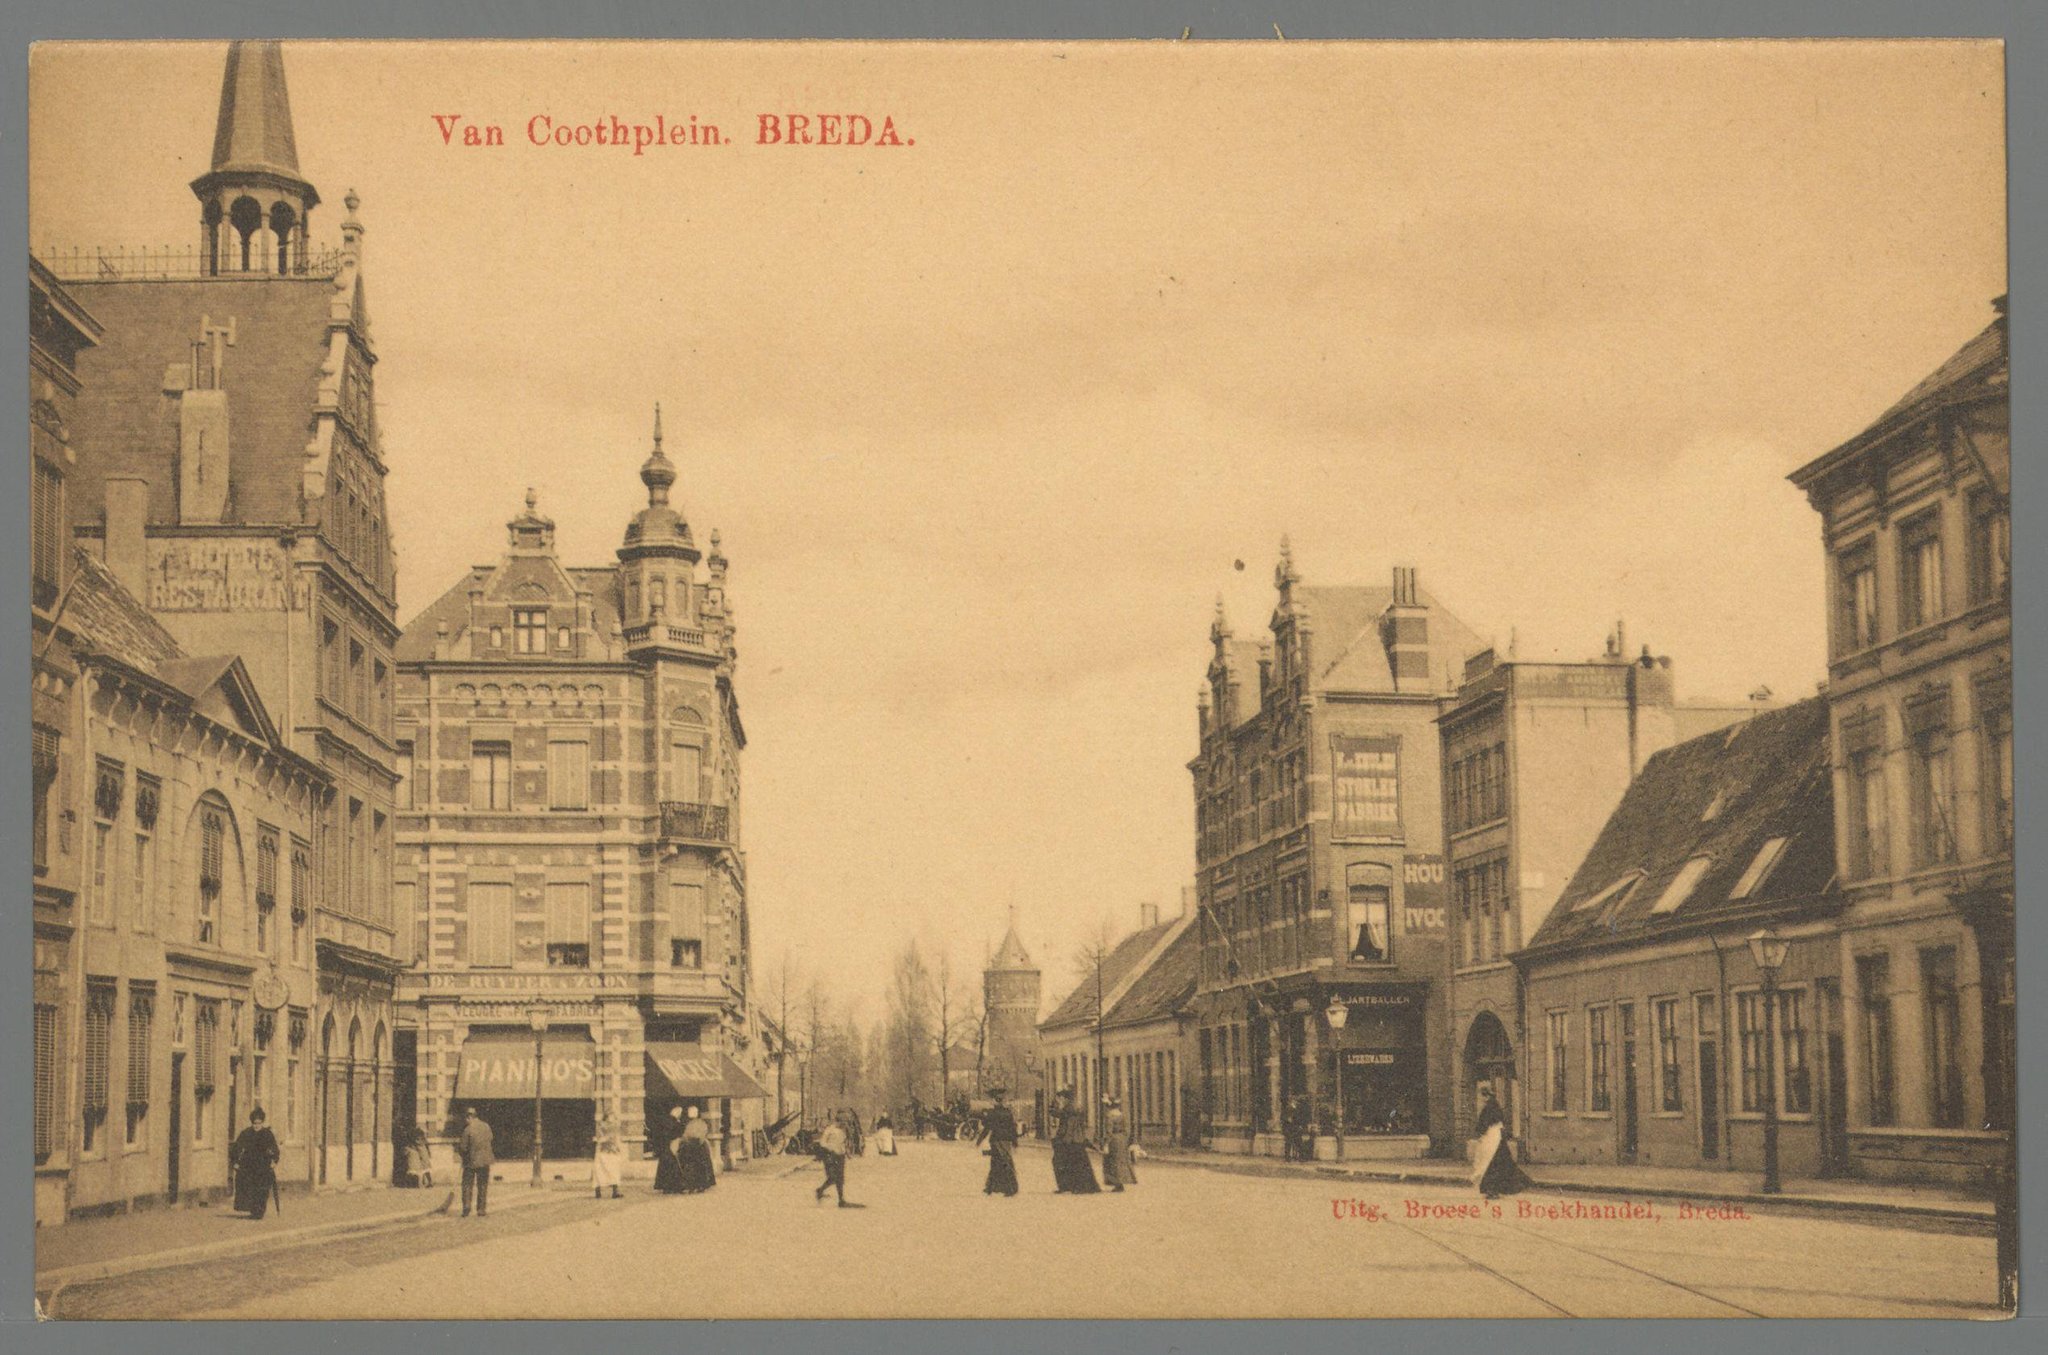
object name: ansichtkaart, prentbriefkaart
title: Van Coothplein. Breda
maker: Anonymous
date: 1905-1927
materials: cardboard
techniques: photograph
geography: breda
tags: square, place, circus, etc.